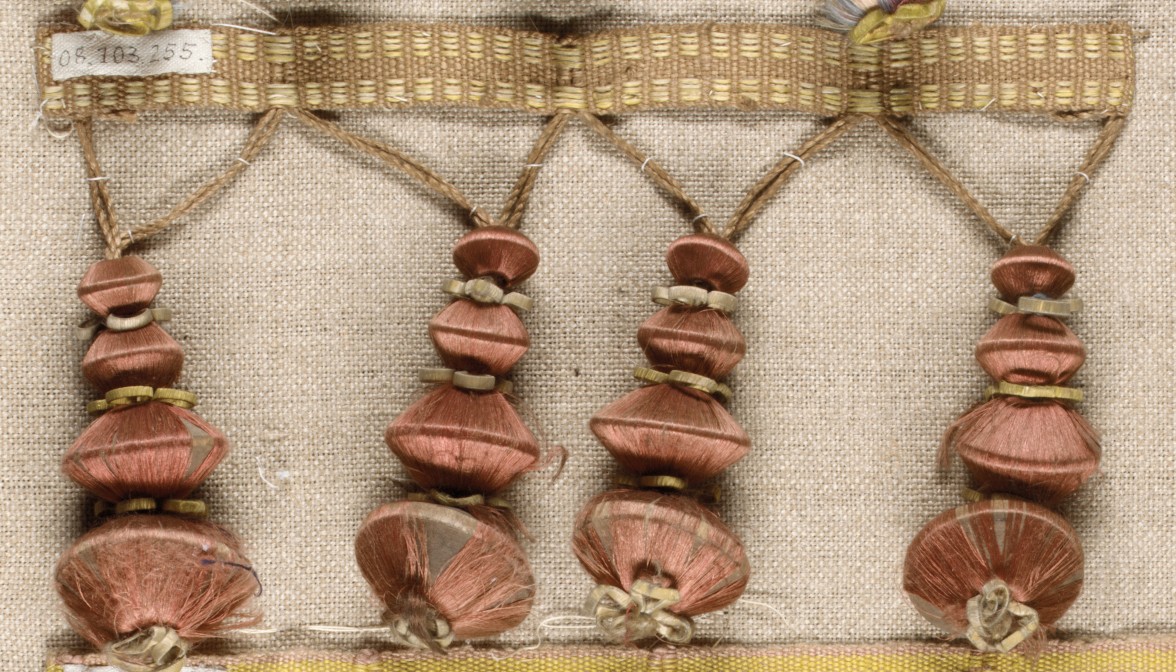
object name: fringe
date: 1801-1900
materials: silk